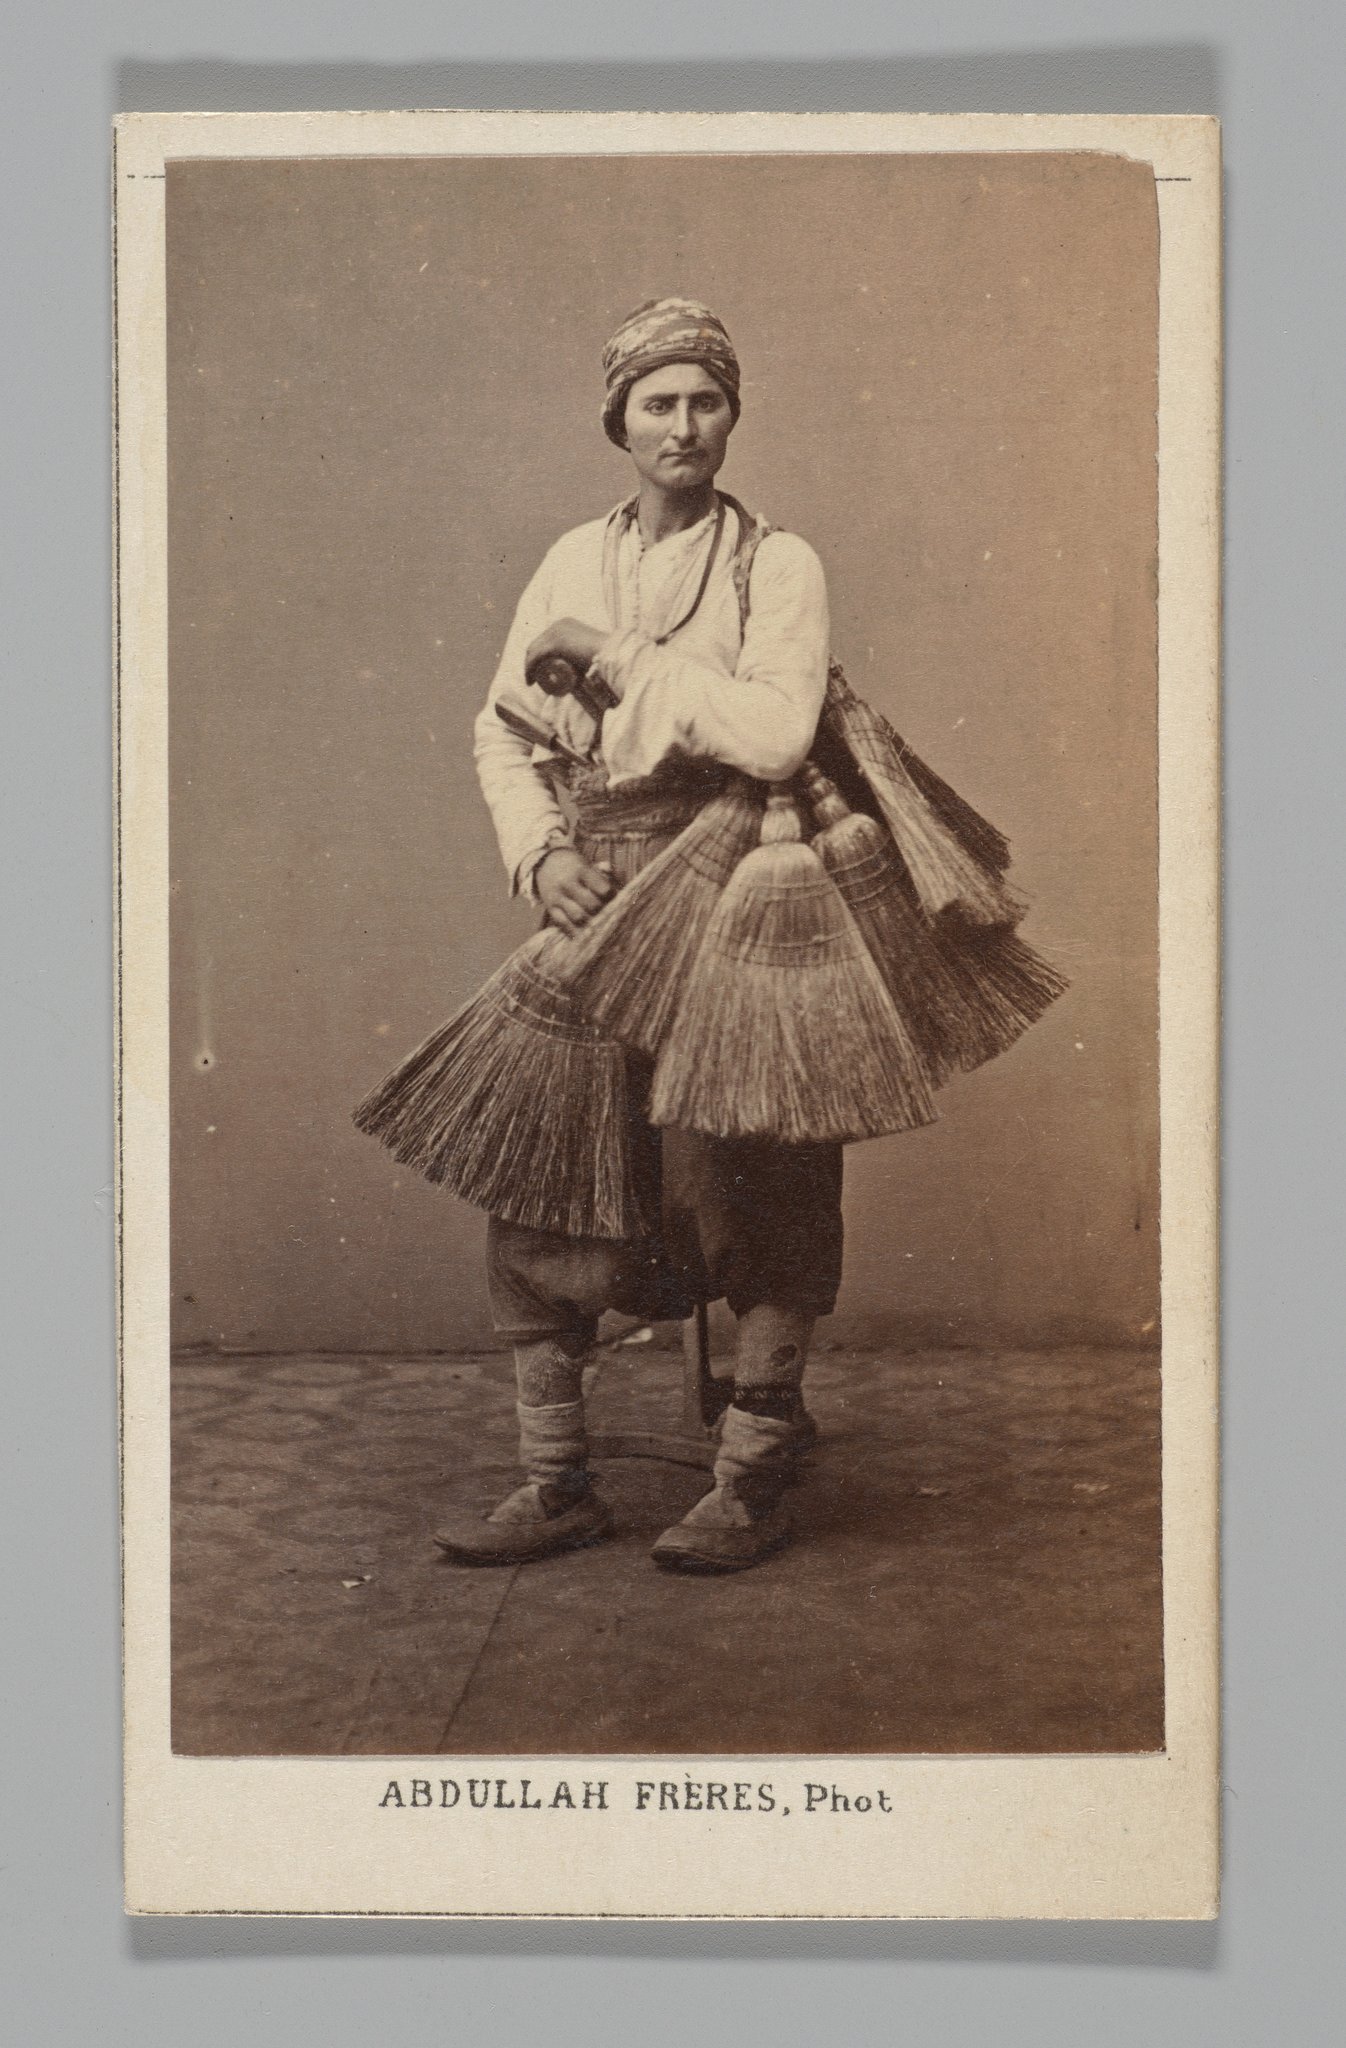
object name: carte de visite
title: [Studio Portrait: Person with Brooms, Syria]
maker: abdullah frères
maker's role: photography studio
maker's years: 1858-1899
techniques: albumen silver print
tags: men,portraits,brooms